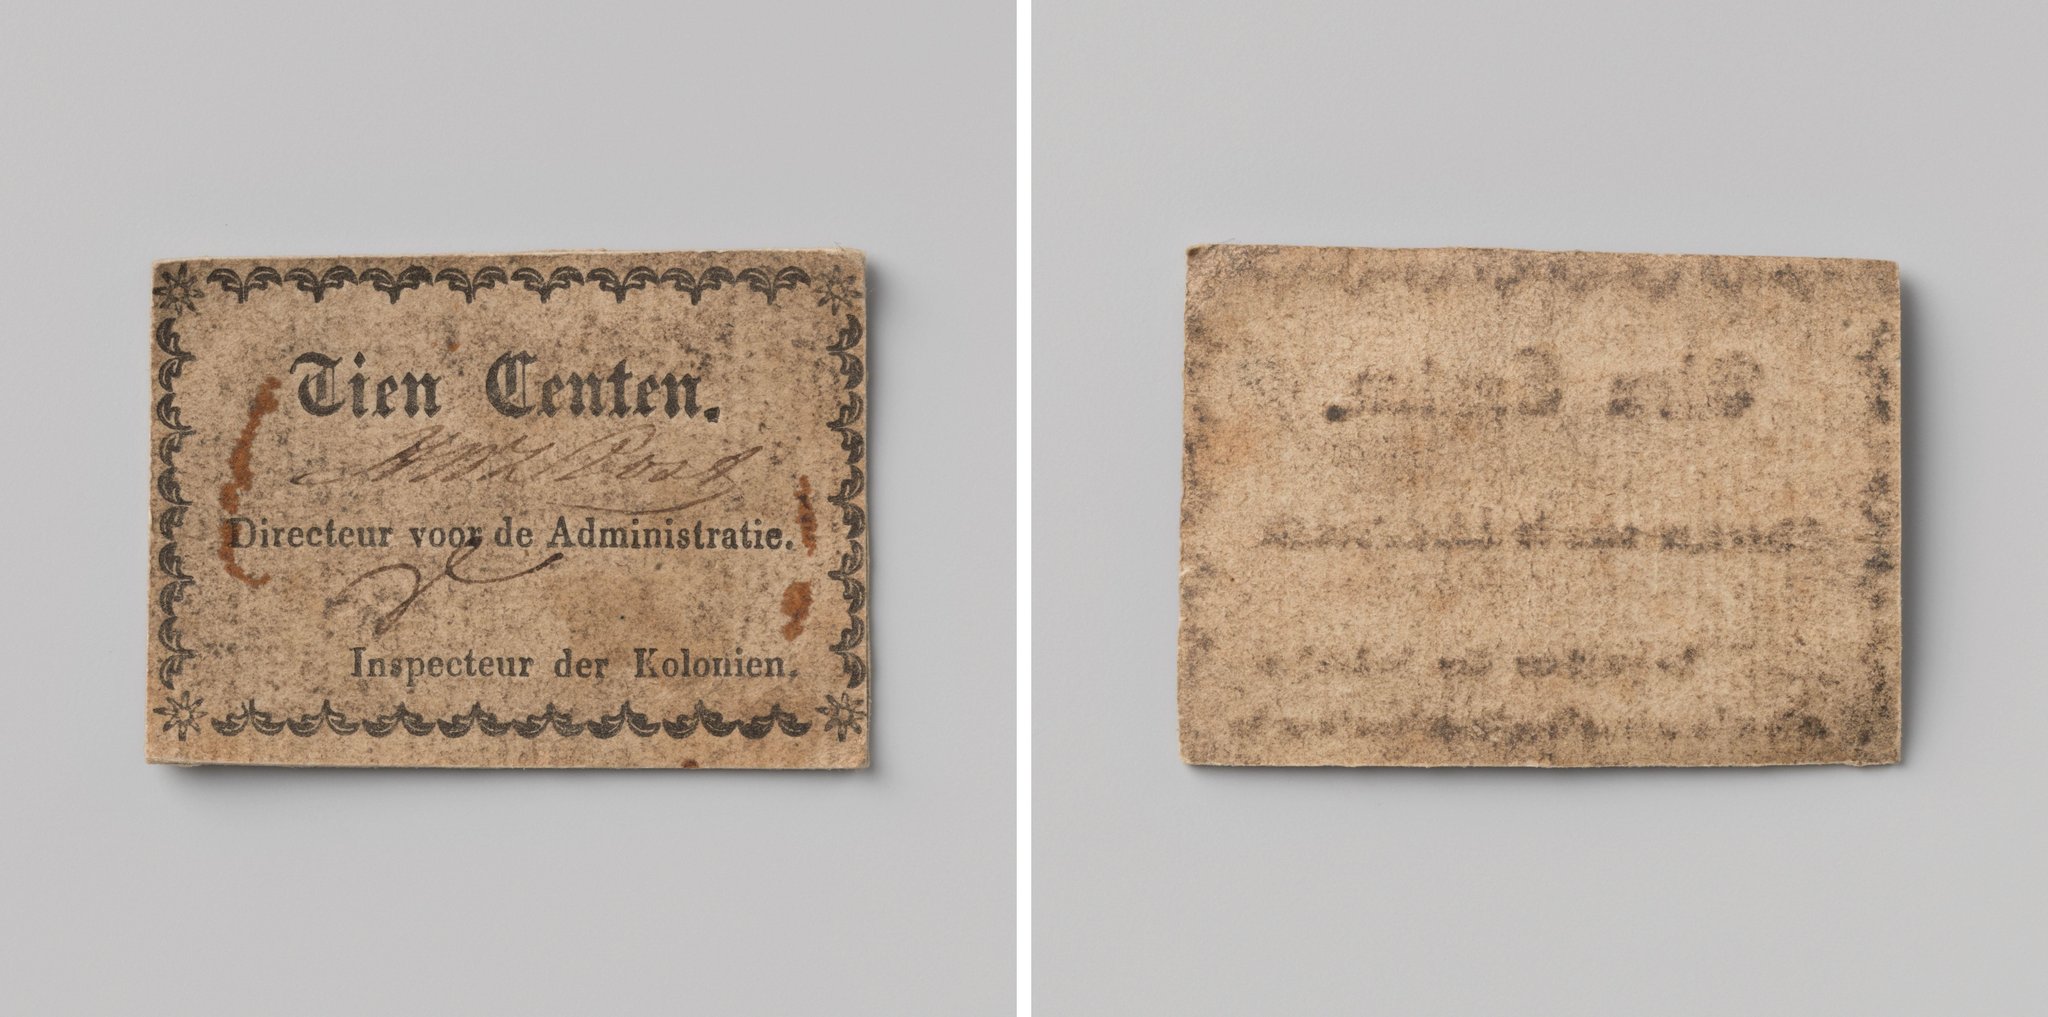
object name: huismunt prison money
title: Huismunt (winkelkaart) ter waarde van tien cent, uitgegeven door de inspecteur der Kolonien van Weldadigheid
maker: Anonymous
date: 1830-1840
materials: cardboard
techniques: printing, writing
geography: frederiksoord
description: eenzijdige, rechthoekige munt van wit karton. Voorzijde: binnen sierrand, op hoeken onderbroken door zevenpuntige sterren: gedrukt opschrift in drie regels; daartussen twee met zwarte inkt geschreven handtekeningen keerzijde: blanco